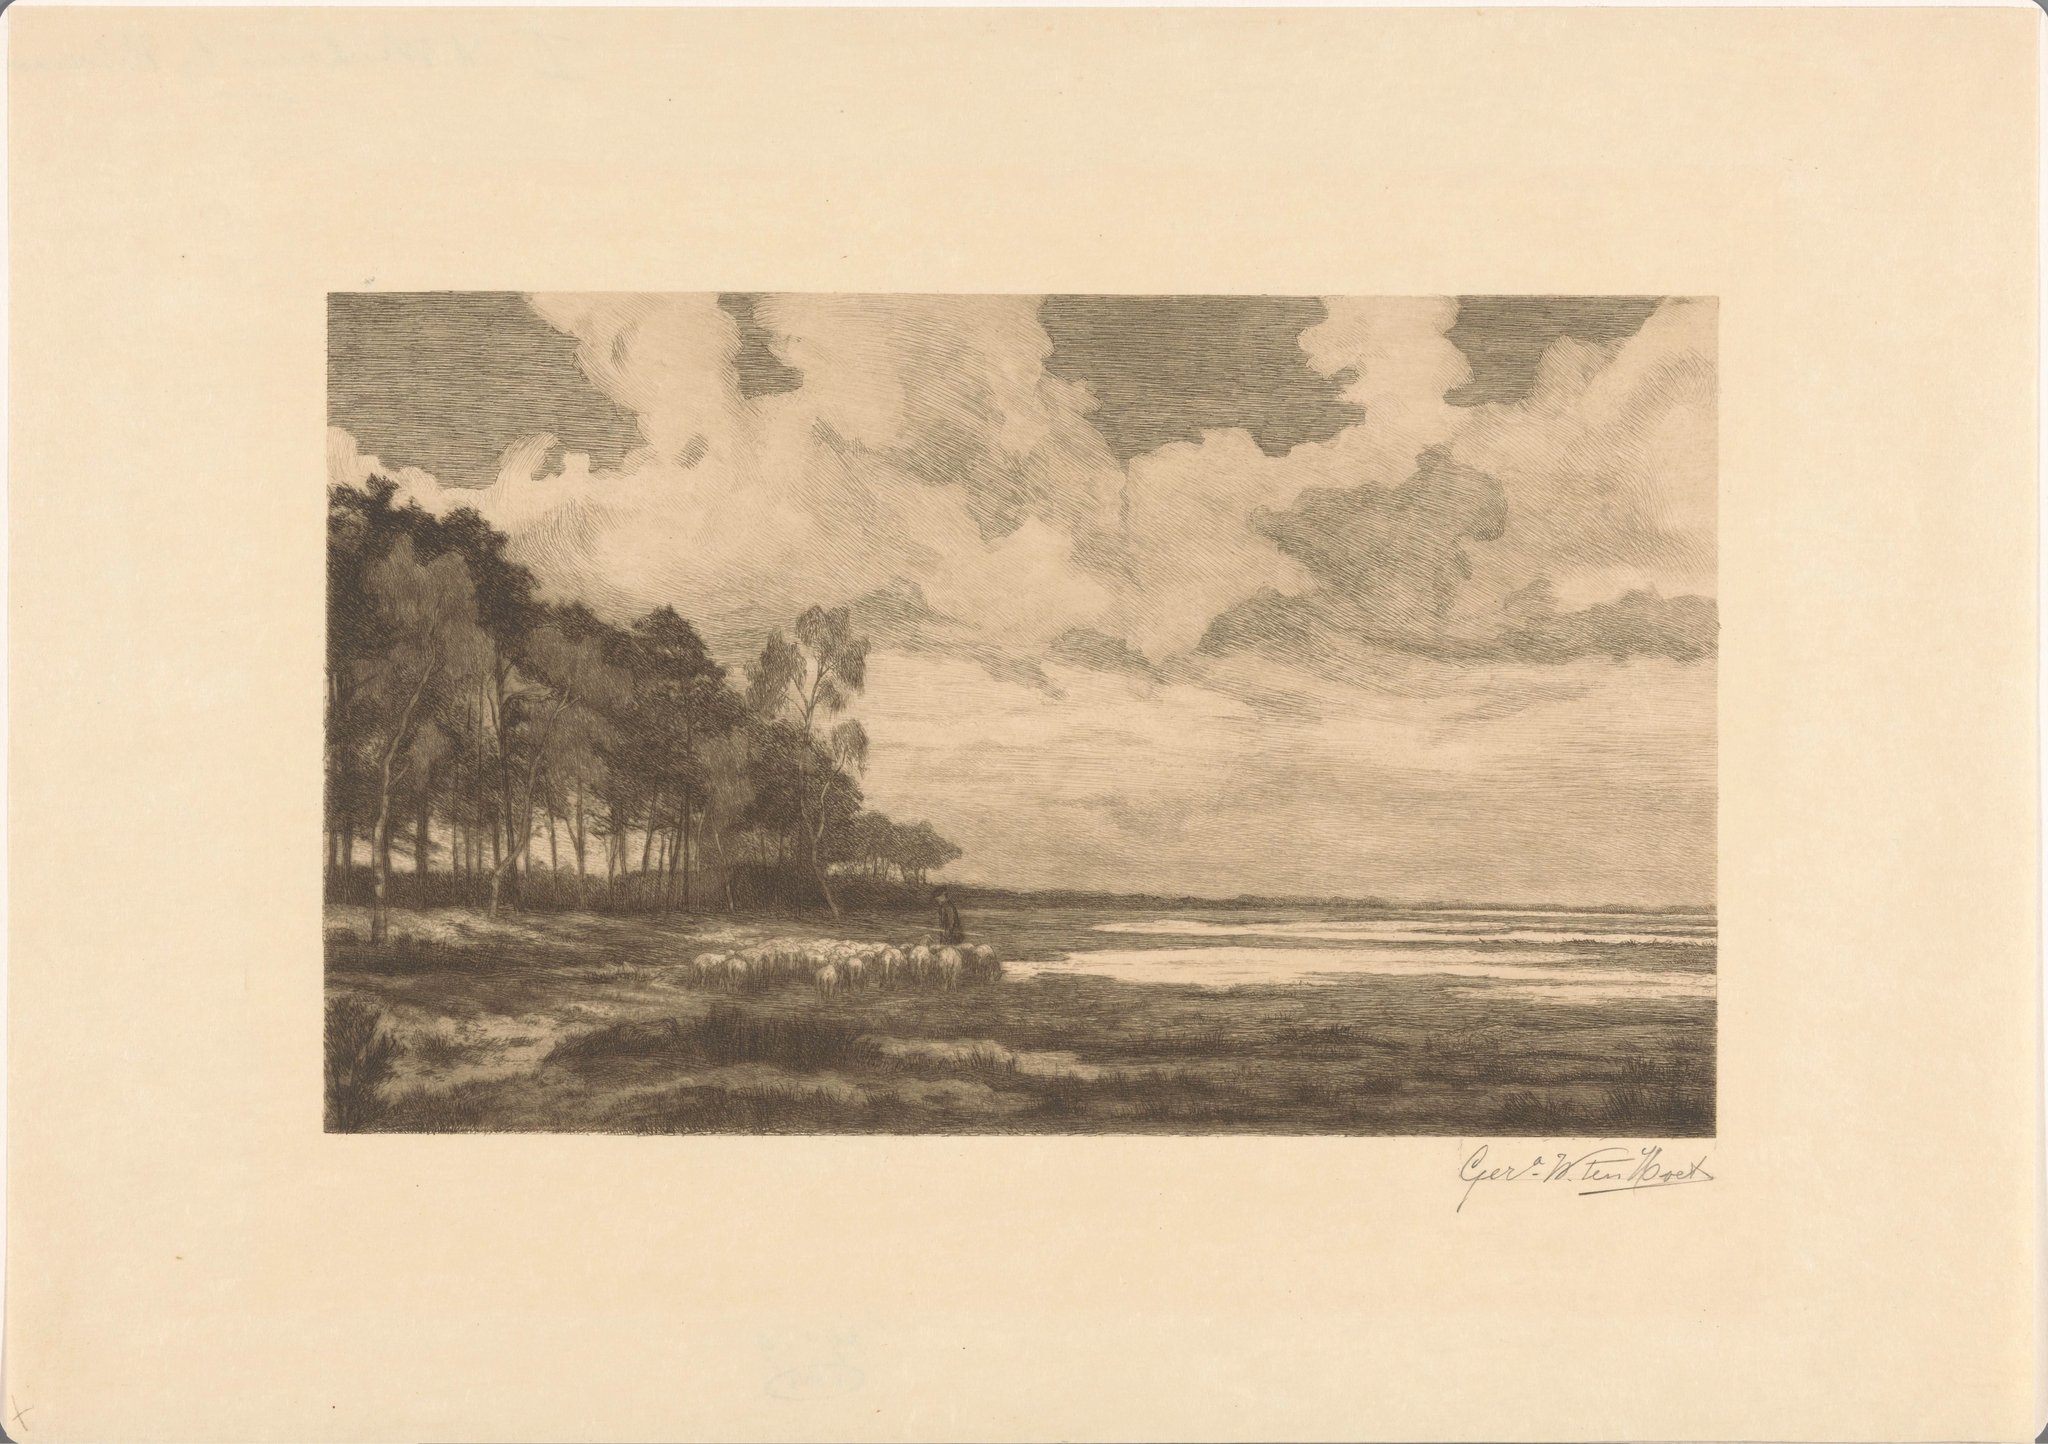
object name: print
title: 't Waschmeer bij Hilversum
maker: gerarda wilhelmina ten hoet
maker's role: print maker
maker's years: 1857-1939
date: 1867-1939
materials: paper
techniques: etching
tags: sheep, fen, du. 'ven', herd, flock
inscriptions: collector's mark: Lugt 2228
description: Rechts het Hilversums Wasmeer met daarnaast een herder en zijn schapenkudde. Links een bosrand.